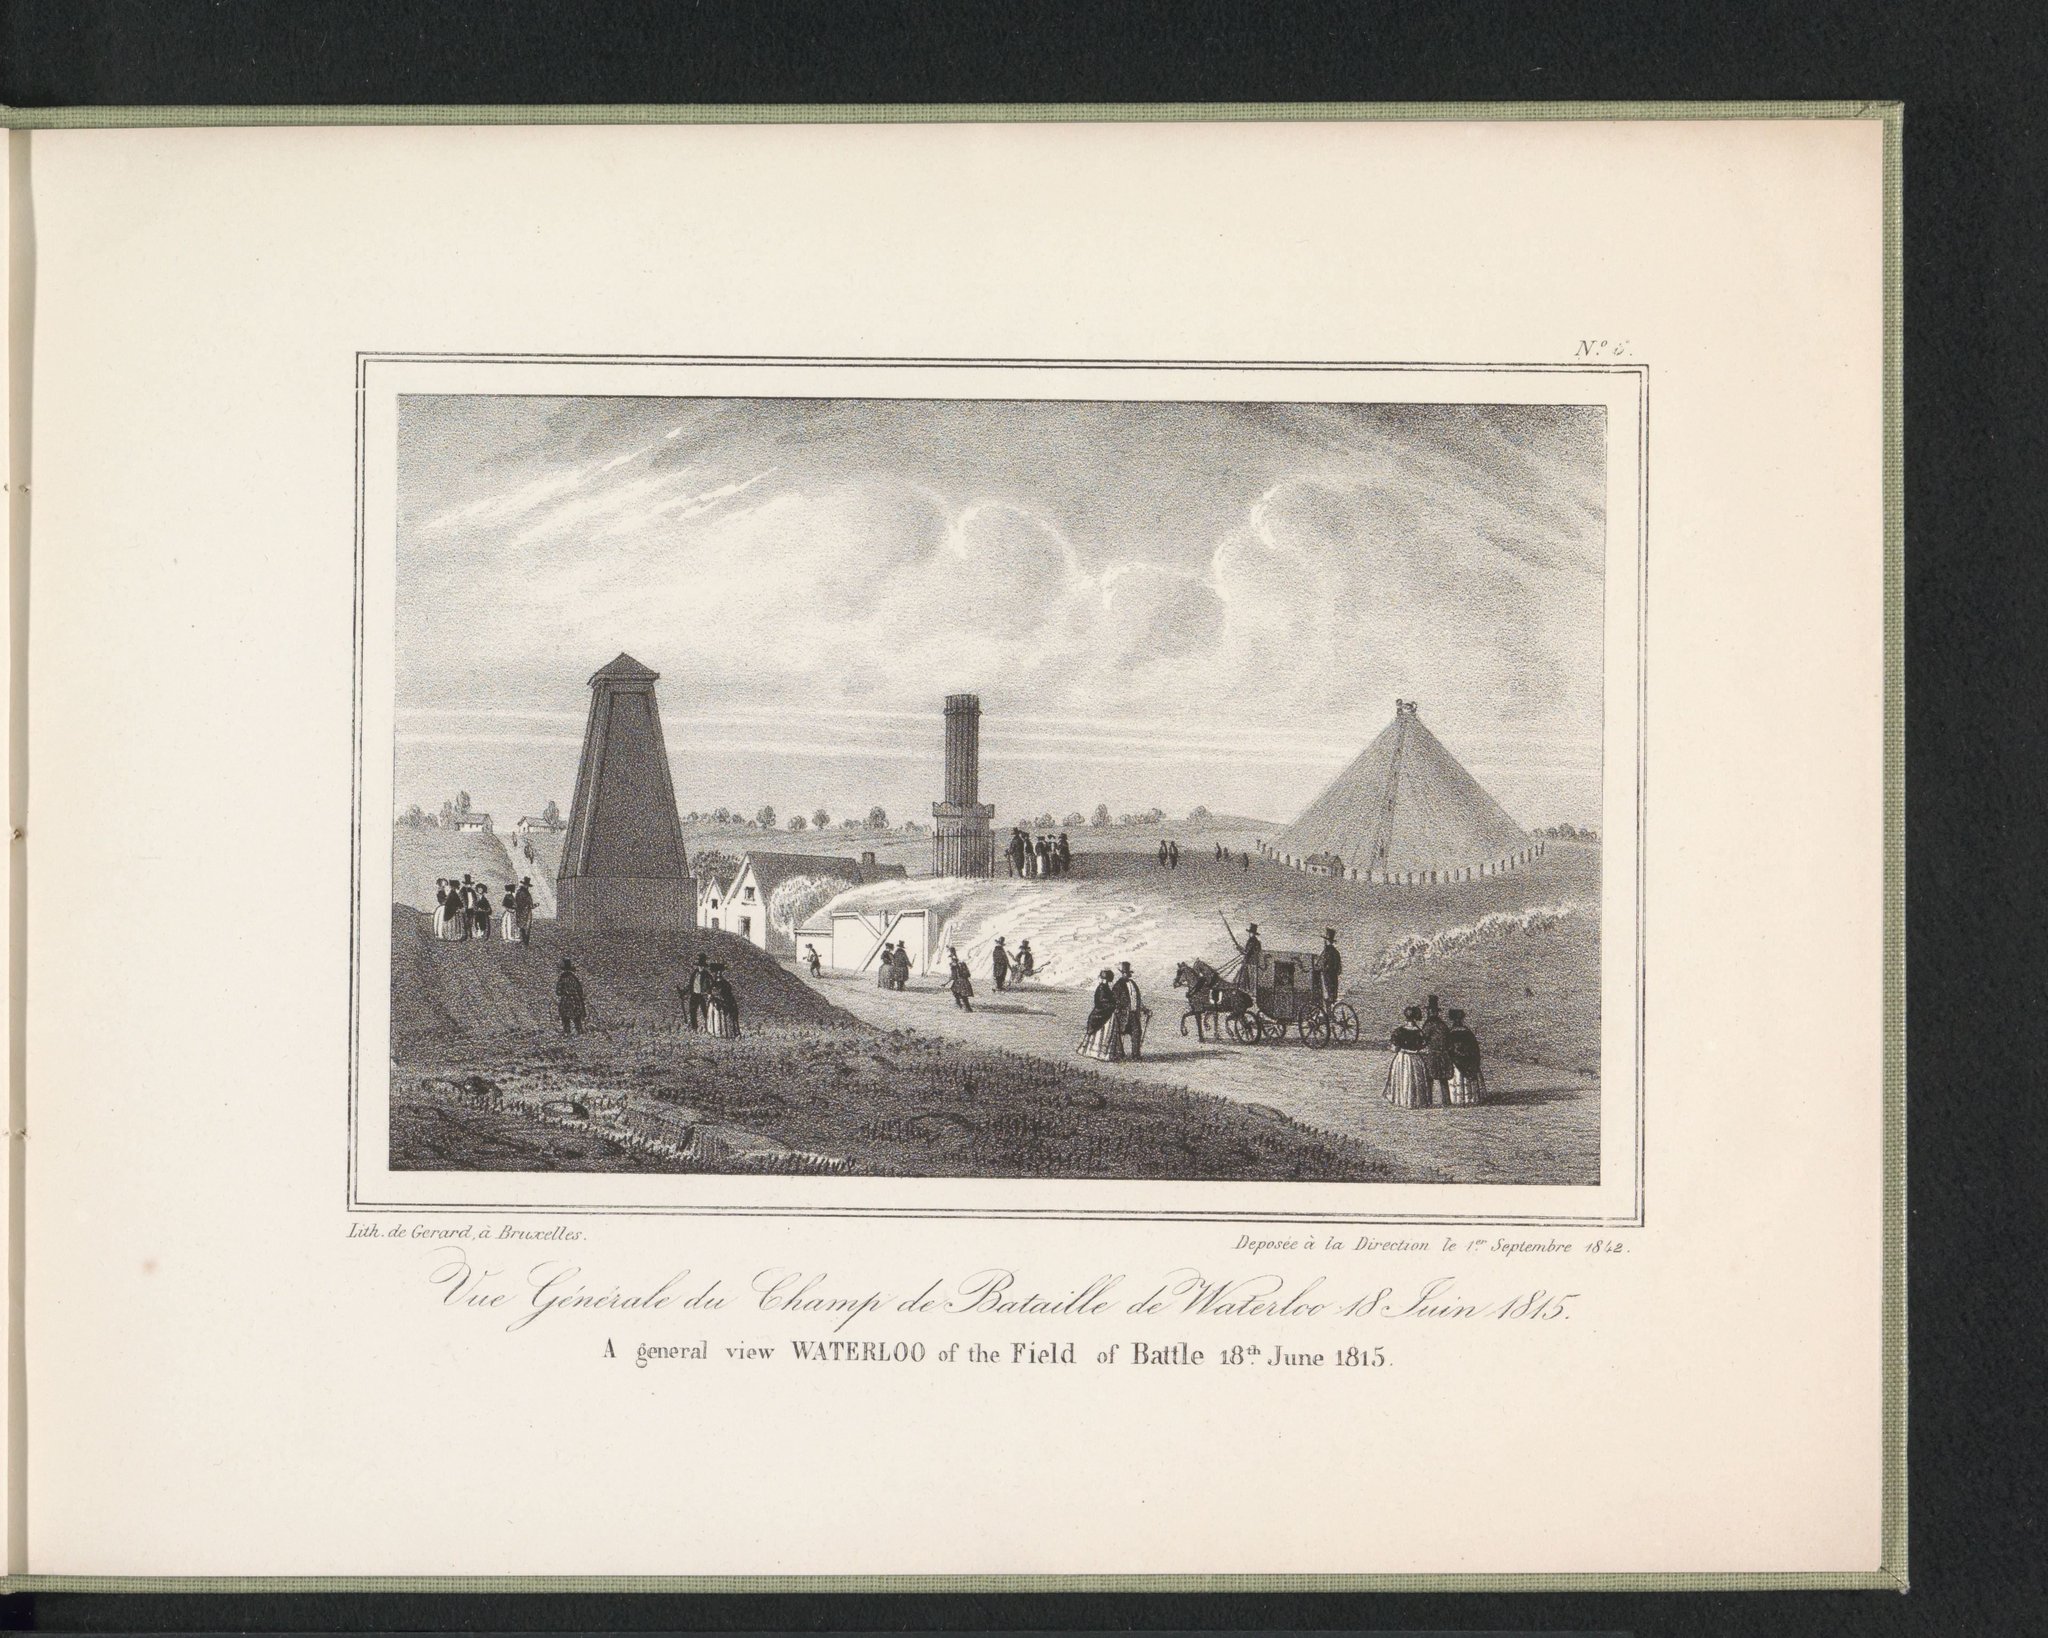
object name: print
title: Slagveld van Waterloo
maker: h. gérard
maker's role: printer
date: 1842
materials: paper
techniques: lithograph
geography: brussels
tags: landscape with monument, waterloo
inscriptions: date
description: Dit album bevat platen die 1842 zijn gedateerd en een kaart die 1846 is gedateerd. Het album is in verschillende edities met verschillende platen verschenen. Zie Atlas van Stolk, dl. VIII, p. 159-163, nr. 6436 voor beschrijvingen van drie van deze uitgaven.